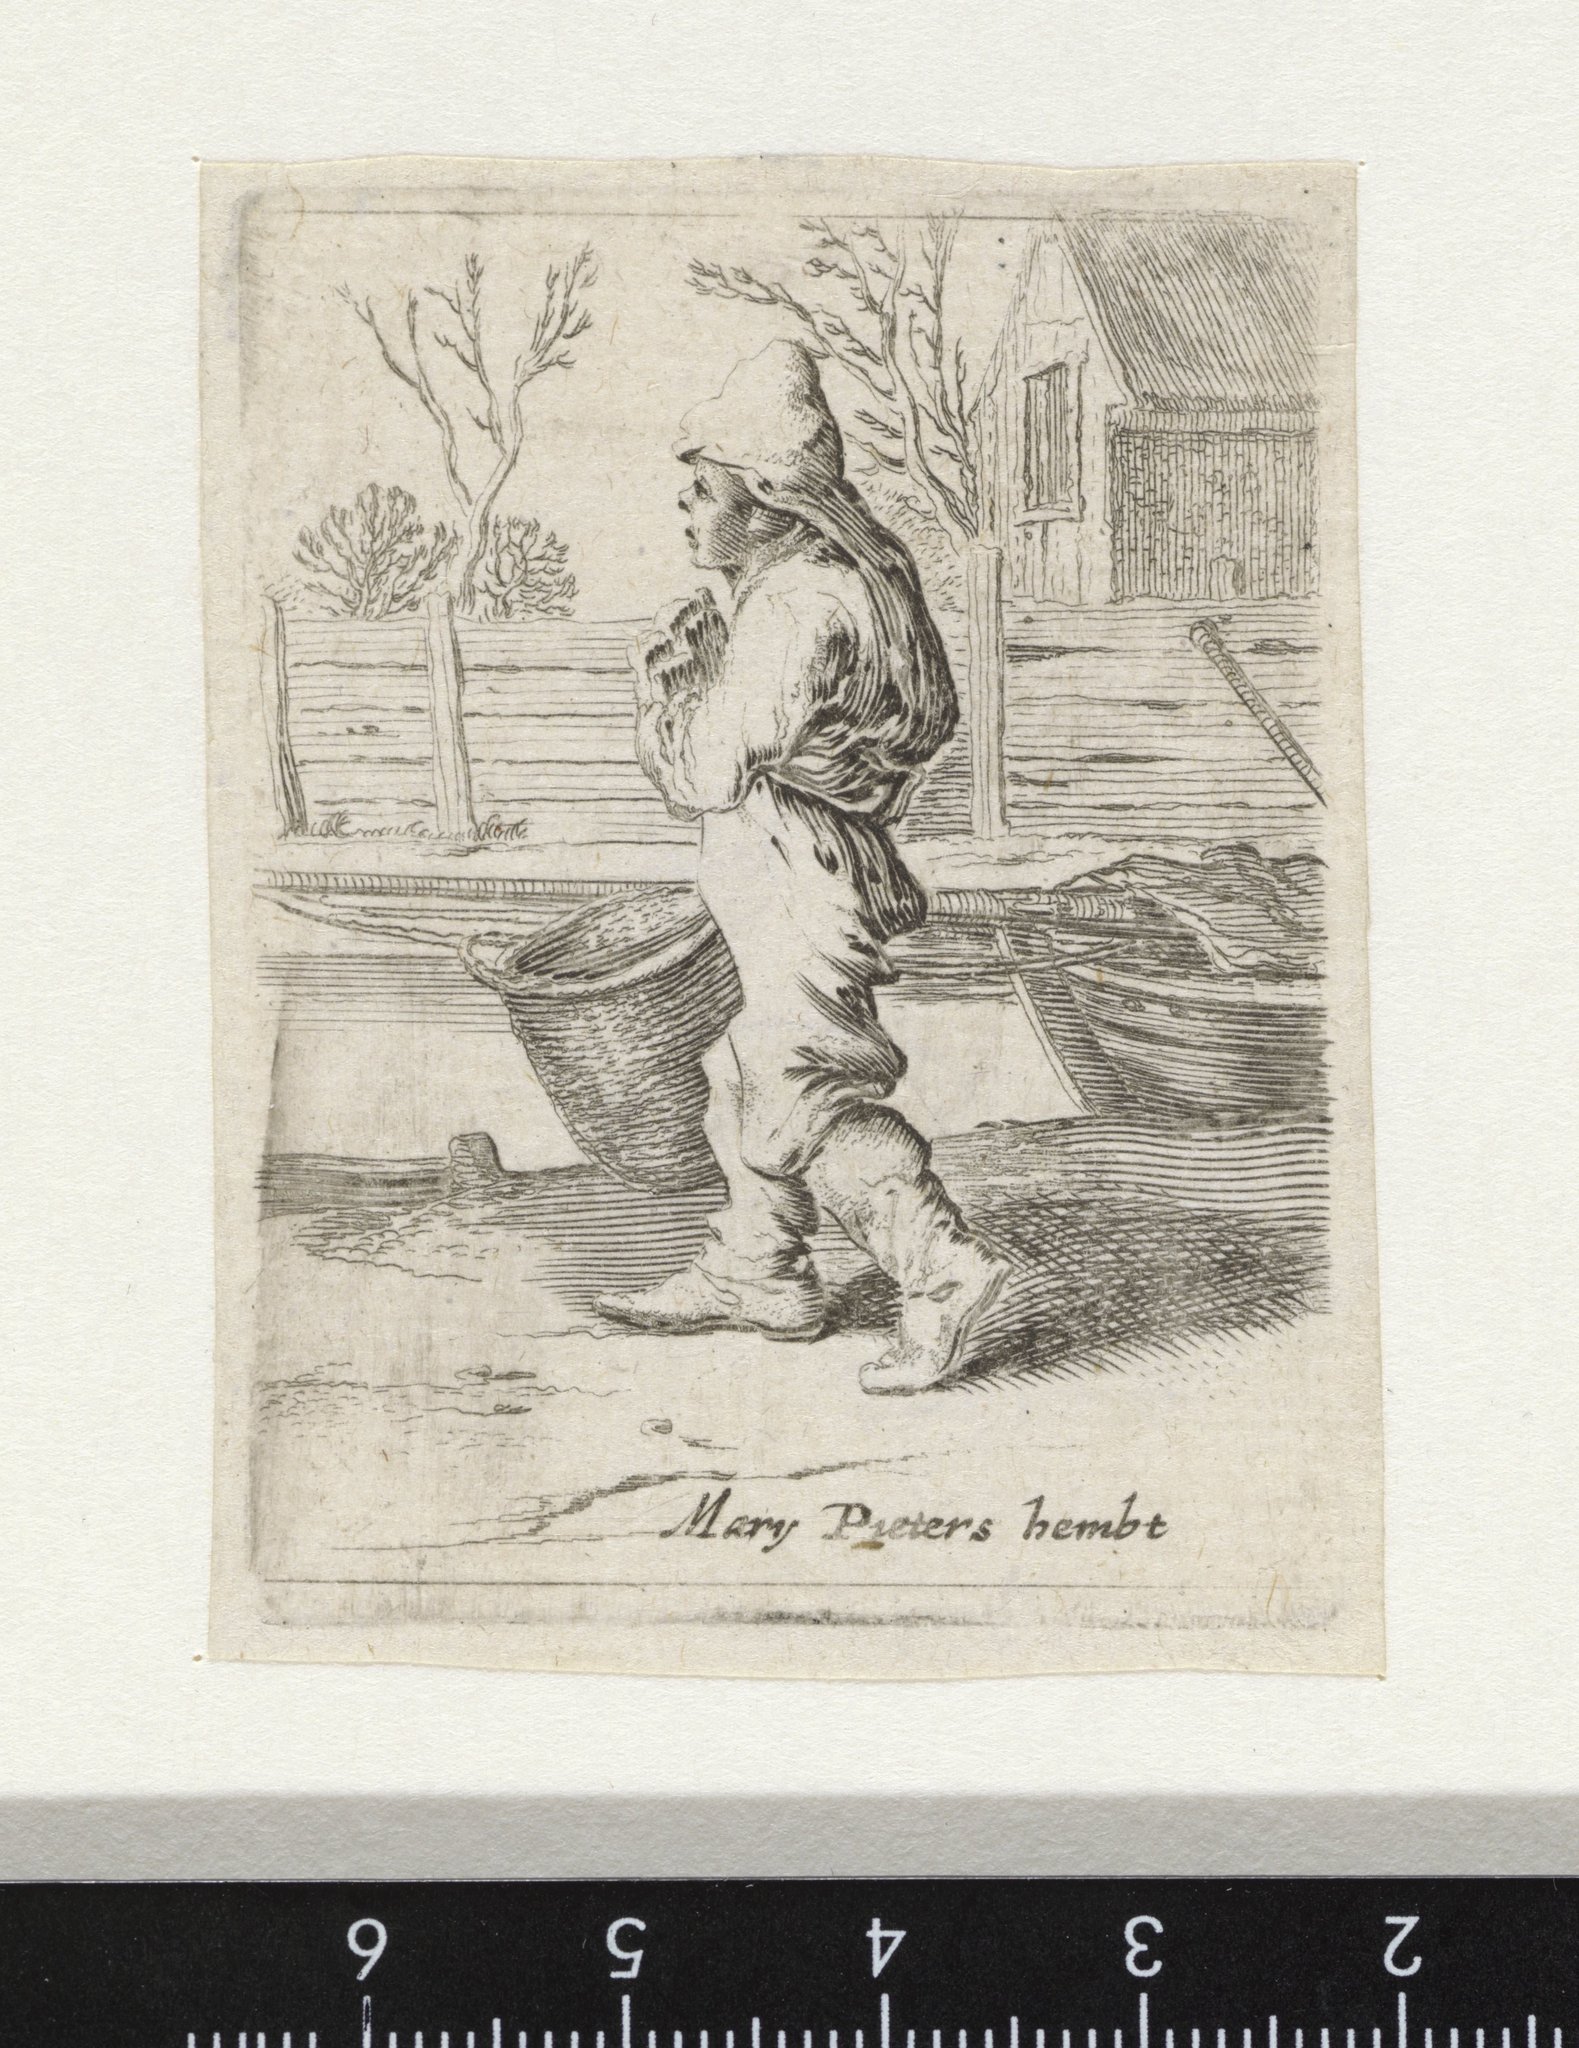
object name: print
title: Genretaferelen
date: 1638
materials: paper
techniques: engraving, etching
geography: amsterdam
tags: fence, wall, paling, farmers, farm (building)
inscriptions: collector's mark: Lugt 2228, collector's mark: Lugt 2760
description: Een boer loopt langs een vaart, waar een rieten mand naast staat. Op de achtergrond een schutting en een boerderij. De prent maakt deel uit van een serie van 32 prenten met genretaferelen.